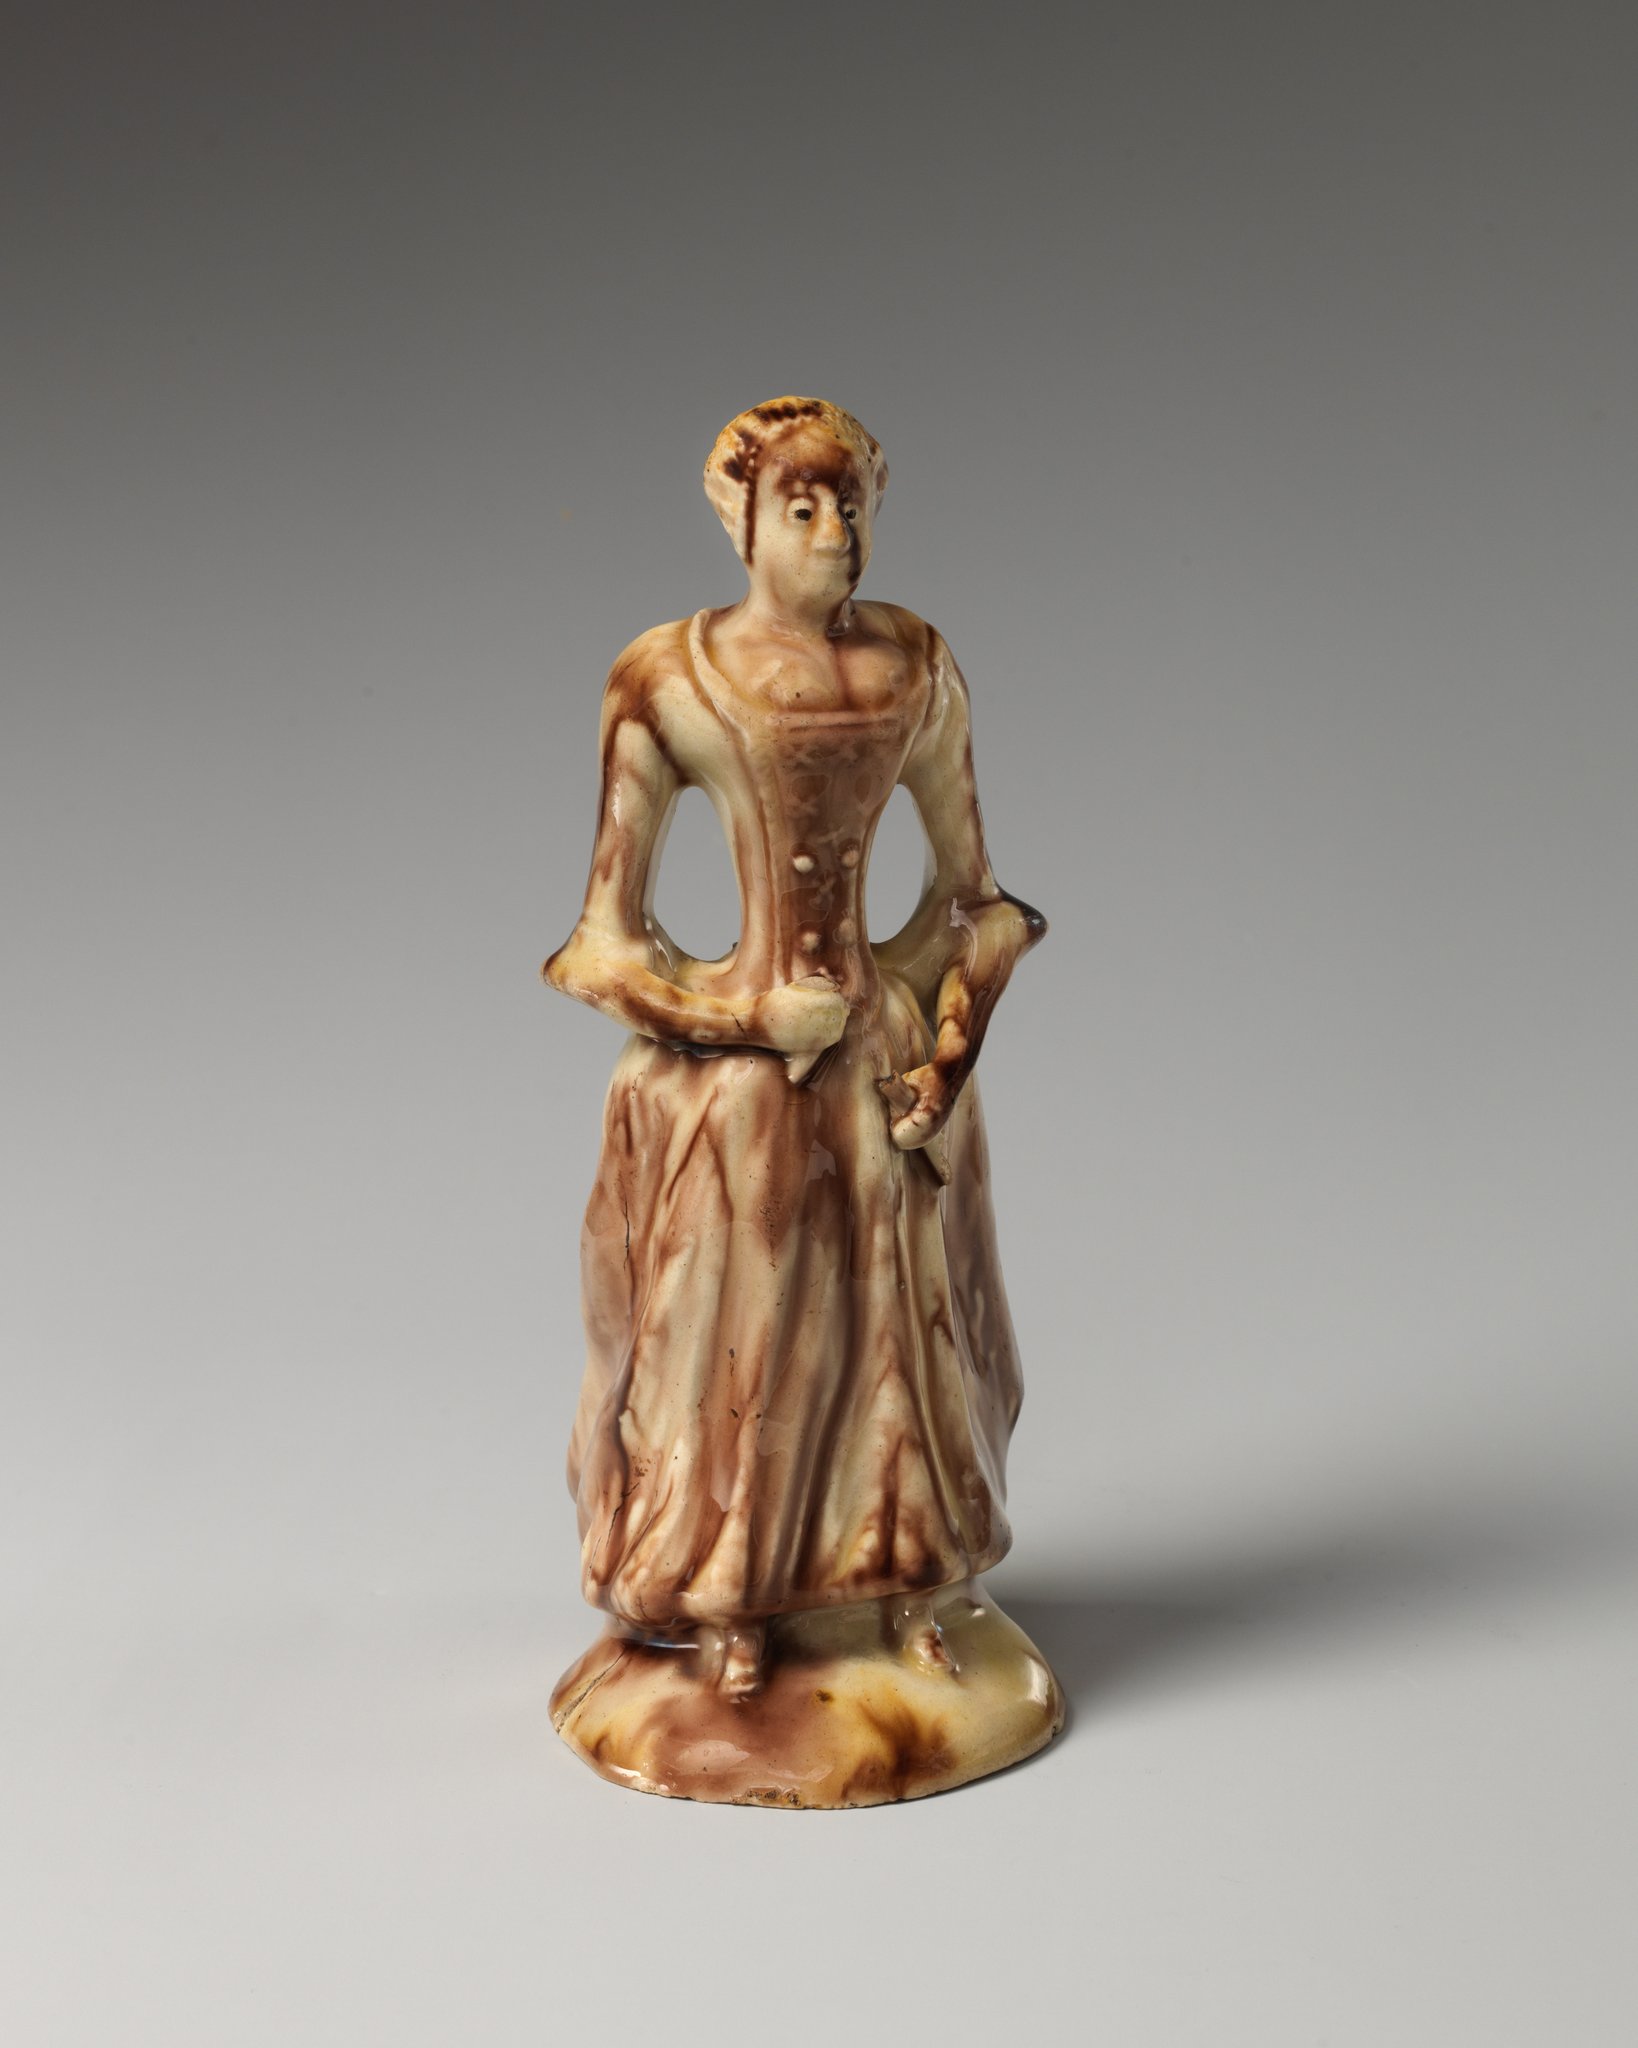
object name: figure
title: Standing woman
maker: whieldon type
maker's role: maker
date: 1750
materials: earthenware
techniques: glazing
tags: women